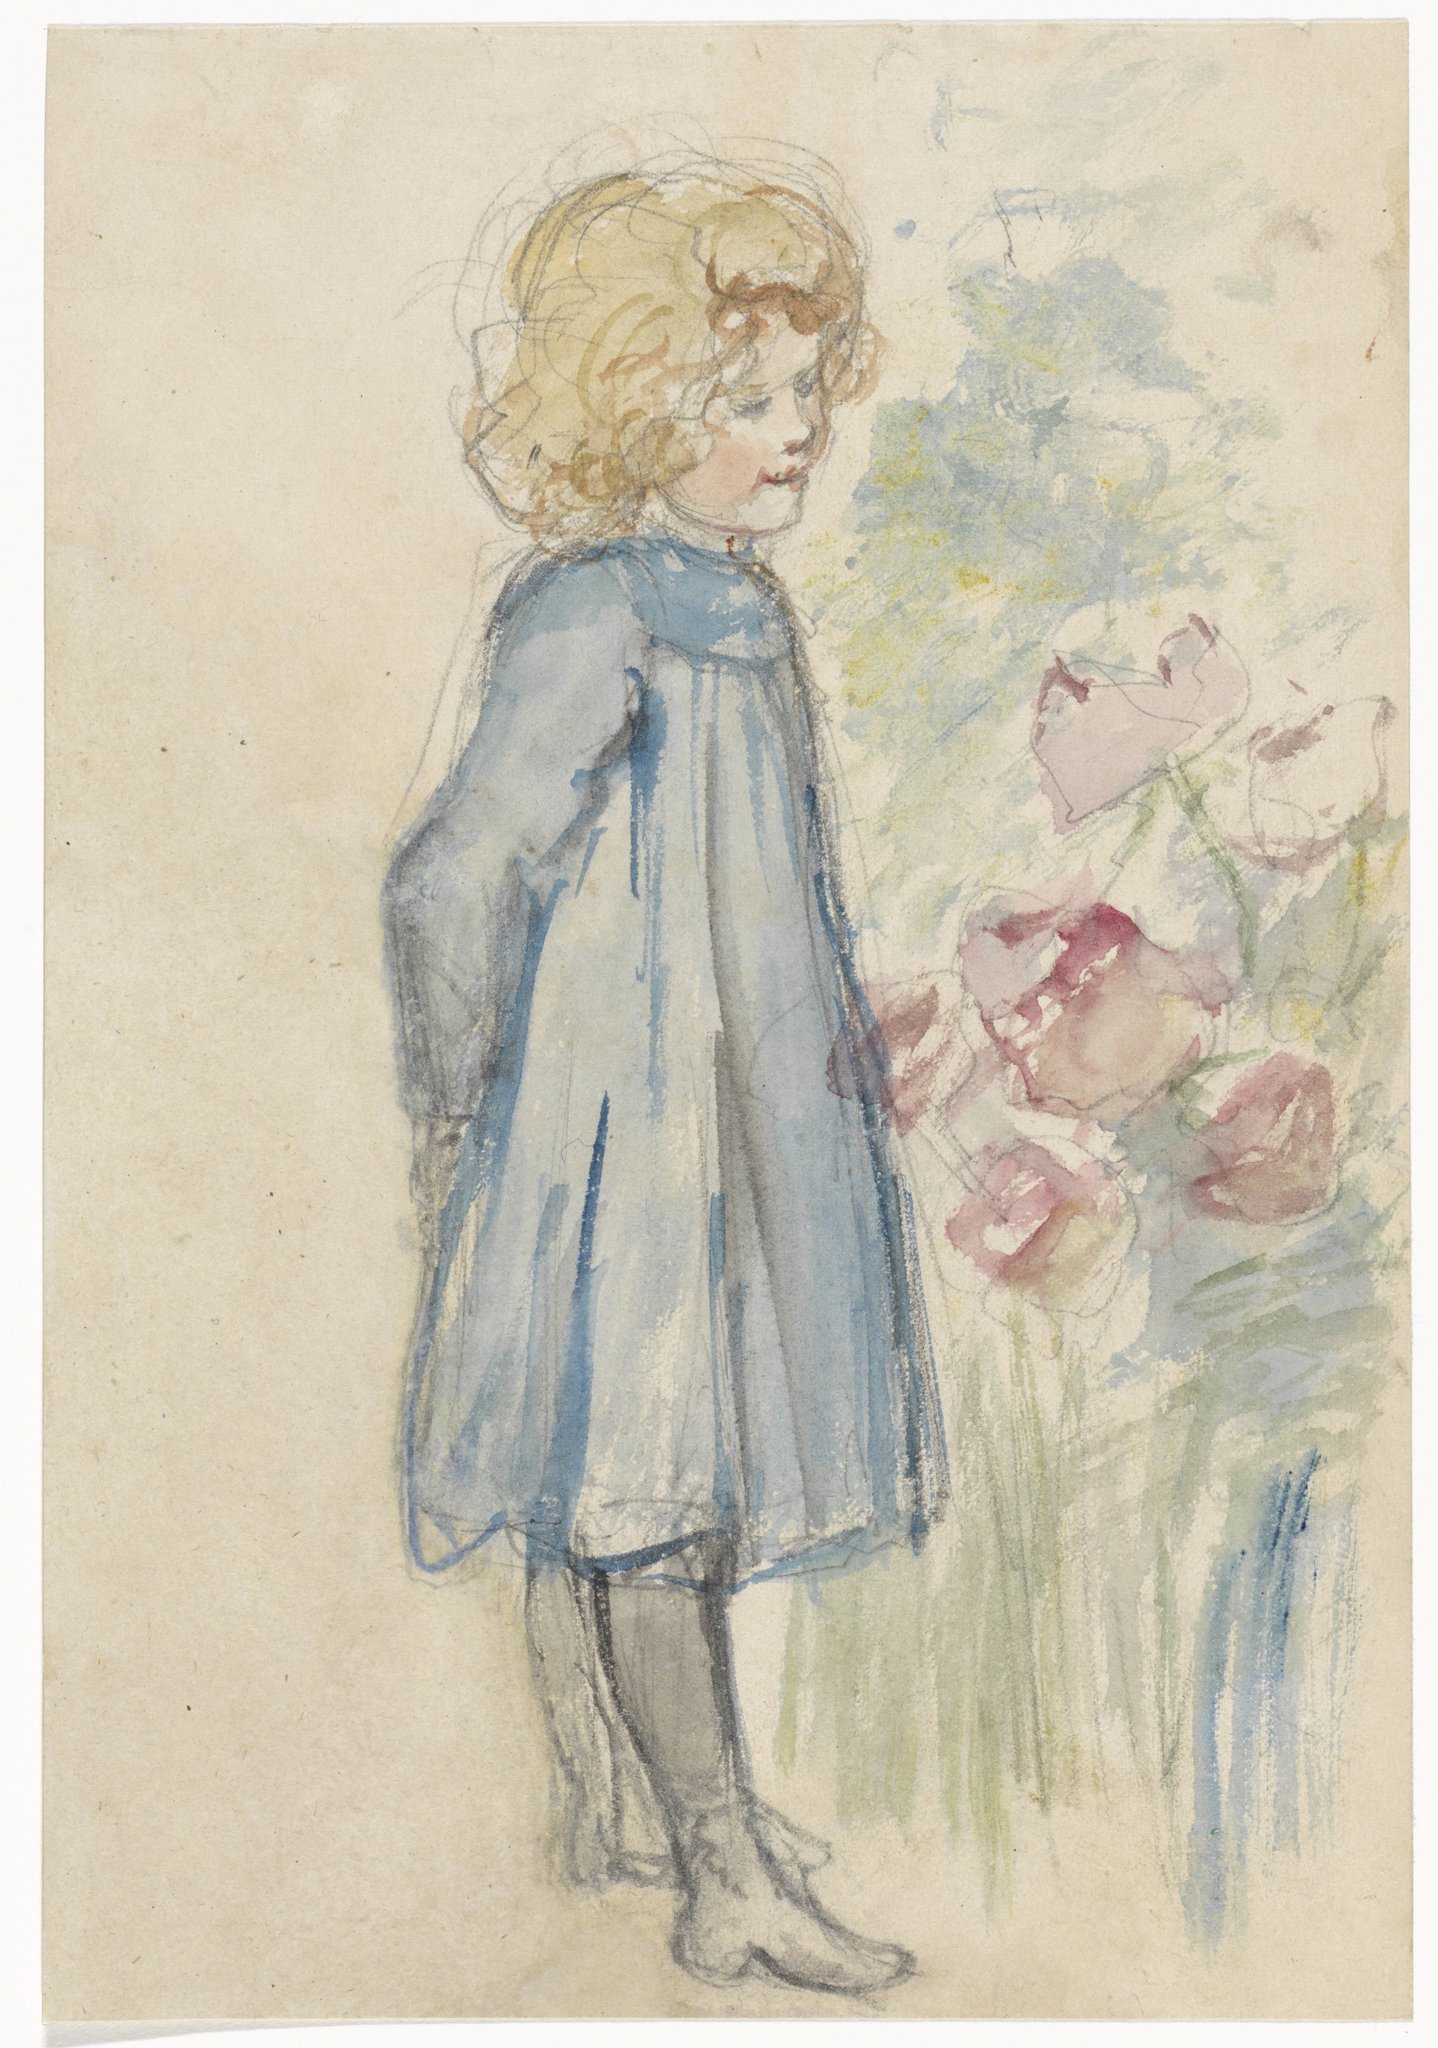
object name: watercolor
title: Staand meisje bij een bloemperk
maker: jozef israëls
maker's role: draughtsman, painter, print maker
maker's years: 1824-1911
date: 1834-1911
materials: paper, pencil, watercolor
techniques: brush